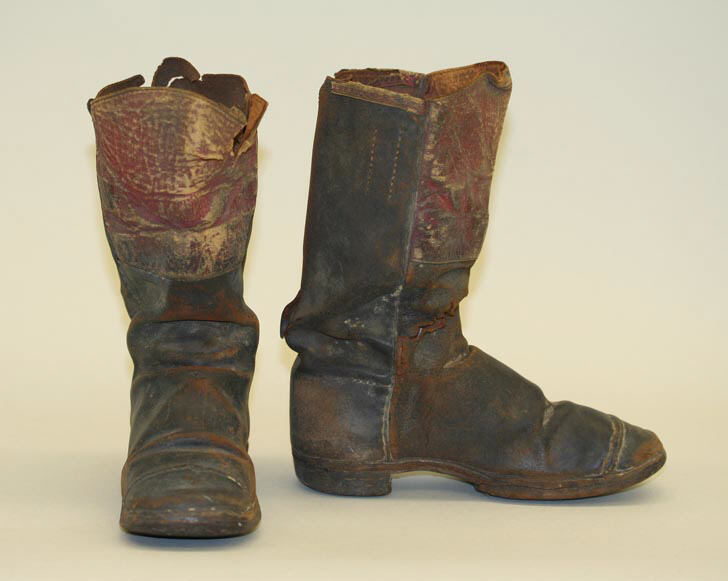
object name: boot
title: Boots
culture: american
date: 1862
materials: leather, wood